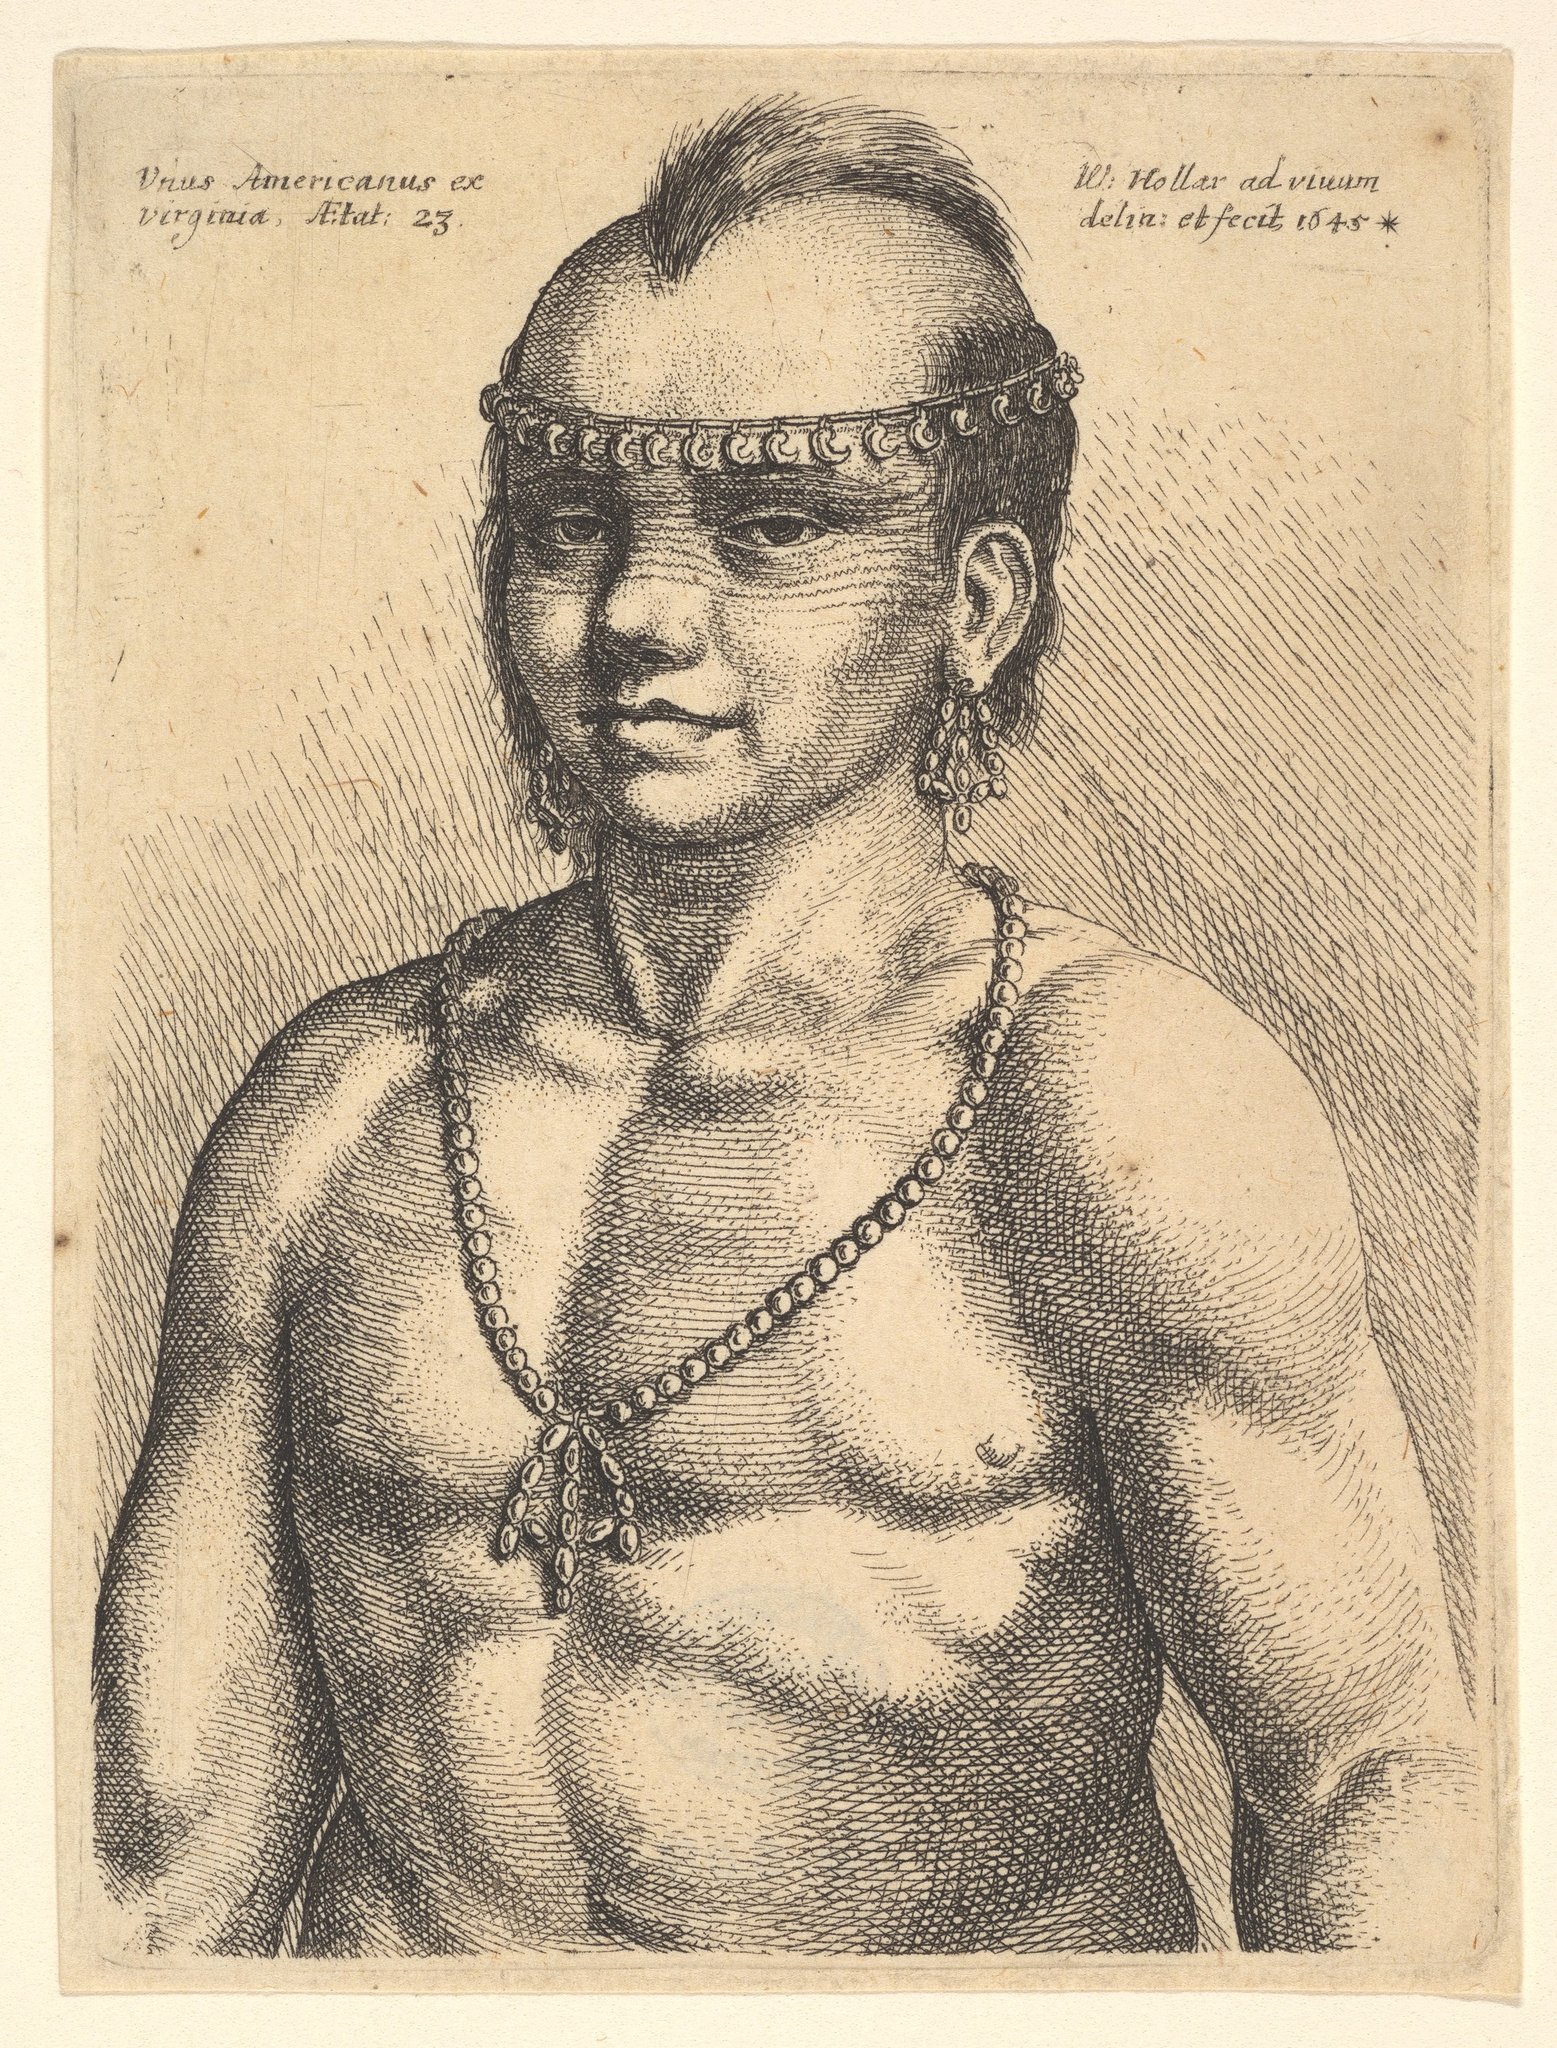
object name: print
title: Unus Americanus ex Virginia (An American from Virginia)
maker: wenceslaus hollar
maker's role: artist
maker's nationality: bohemian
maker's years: 1607-1677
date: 1645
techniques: etching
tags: men,portraits